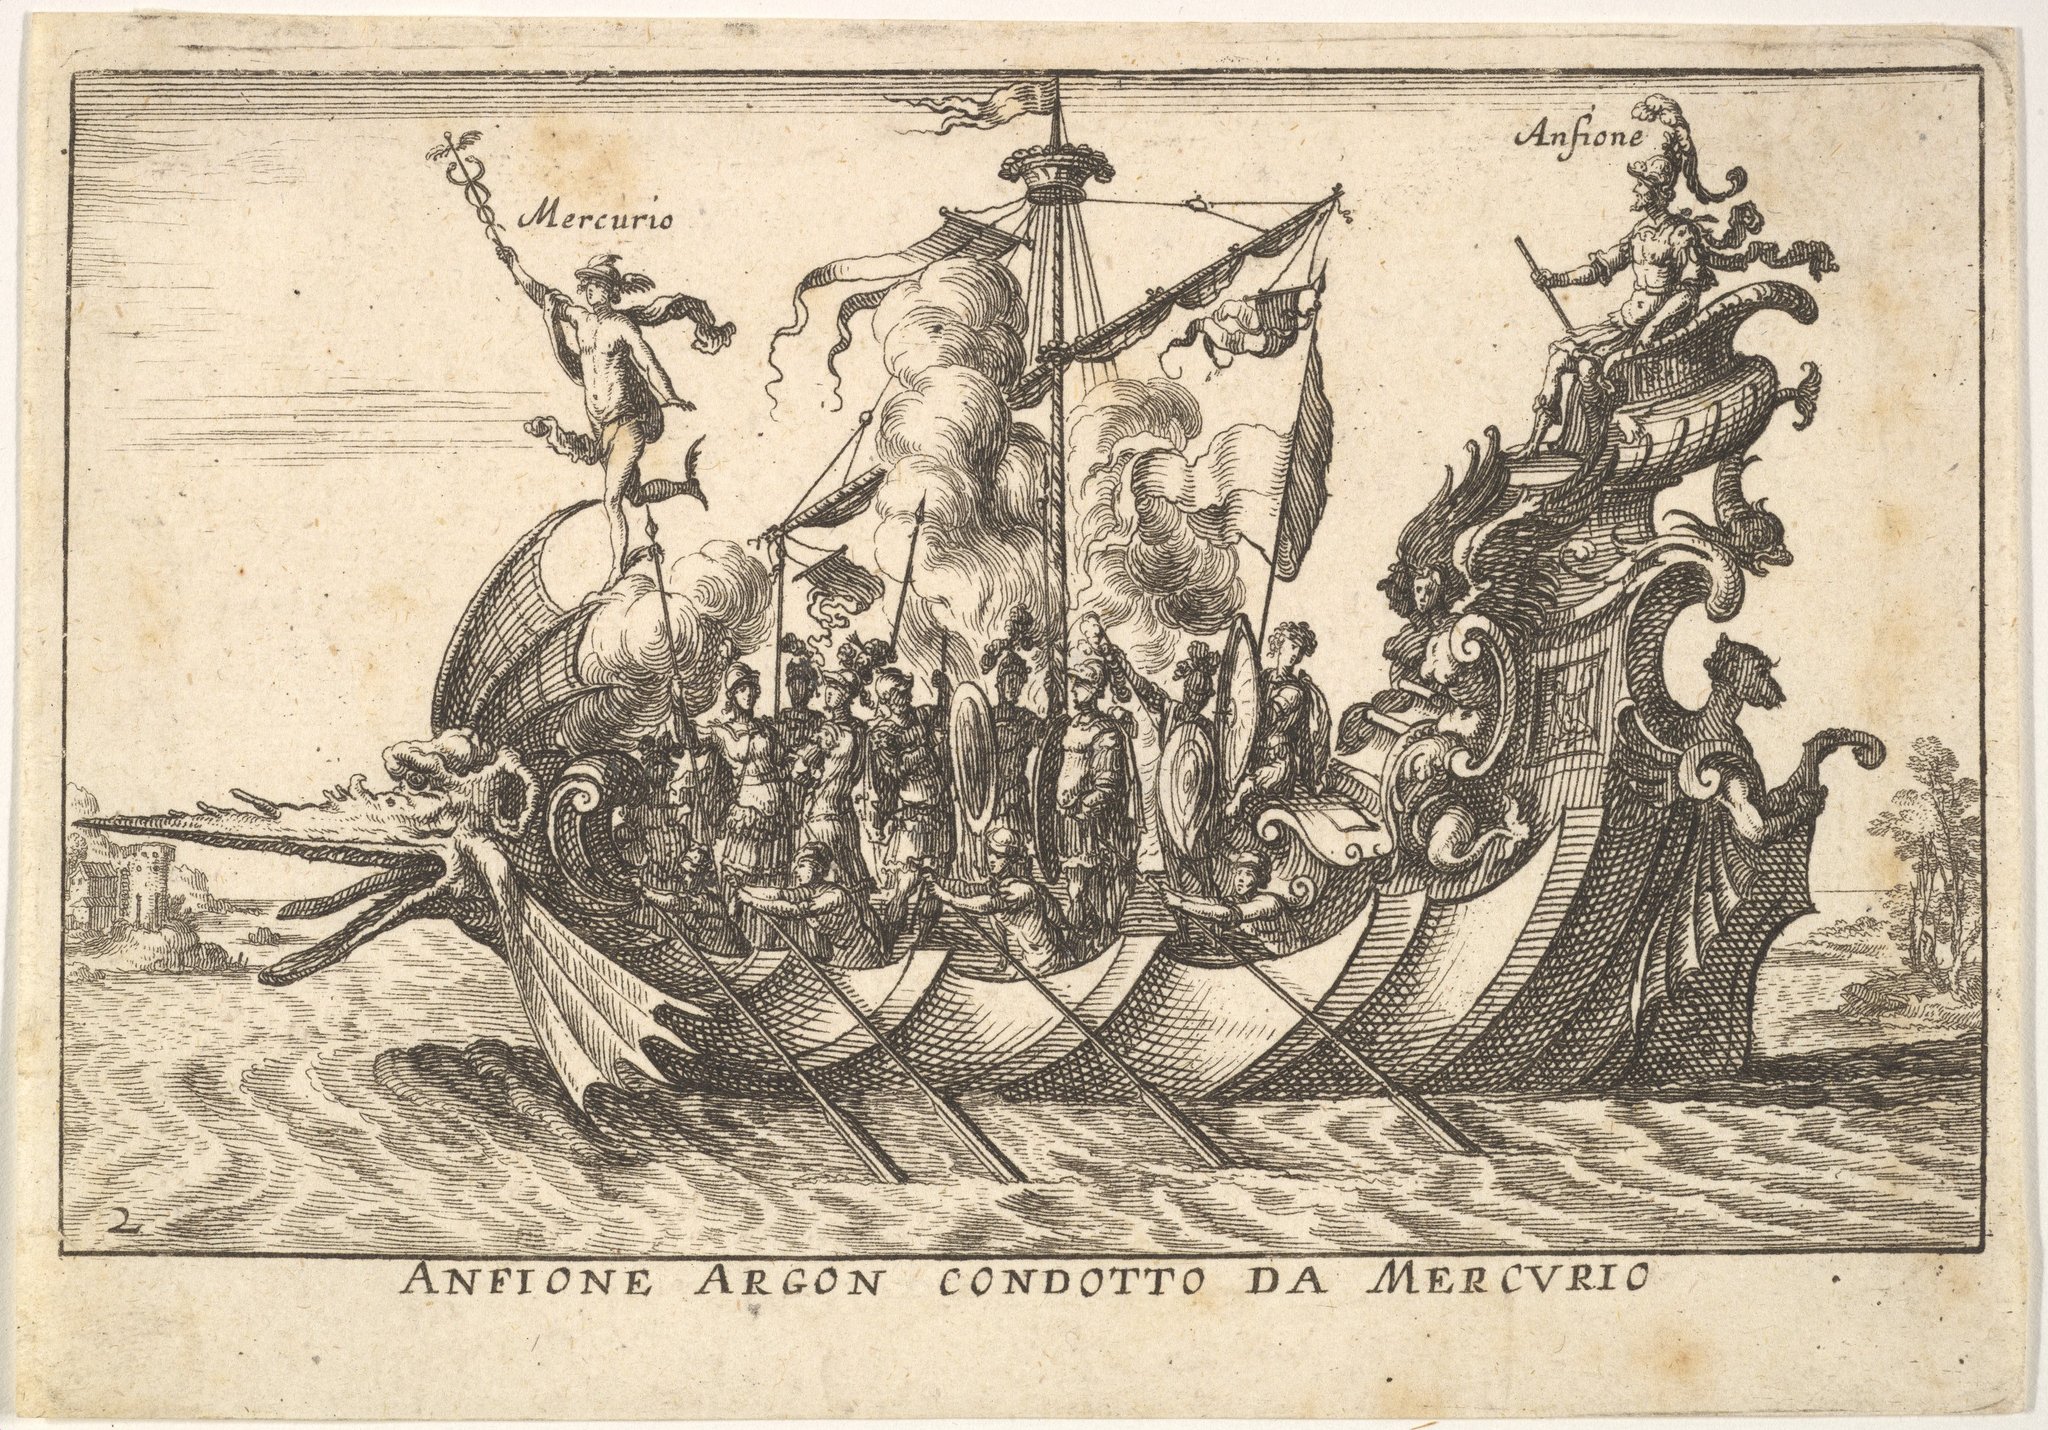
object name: print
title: Plate 2: The Argonaut Amphion led by Mercury (Anfione Argon. condotto da Mercurio), from "The magnificent pageant on the river Arno in Florence for the marriage of the Grand Duke" (Le Magnifique carousel fait sur le fleuve de l'Arne a Florence, pour le mariage du Grand Duc)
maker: Anonymous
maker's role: artist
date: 1664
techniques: etching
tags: soldiers,men,mercury,ships